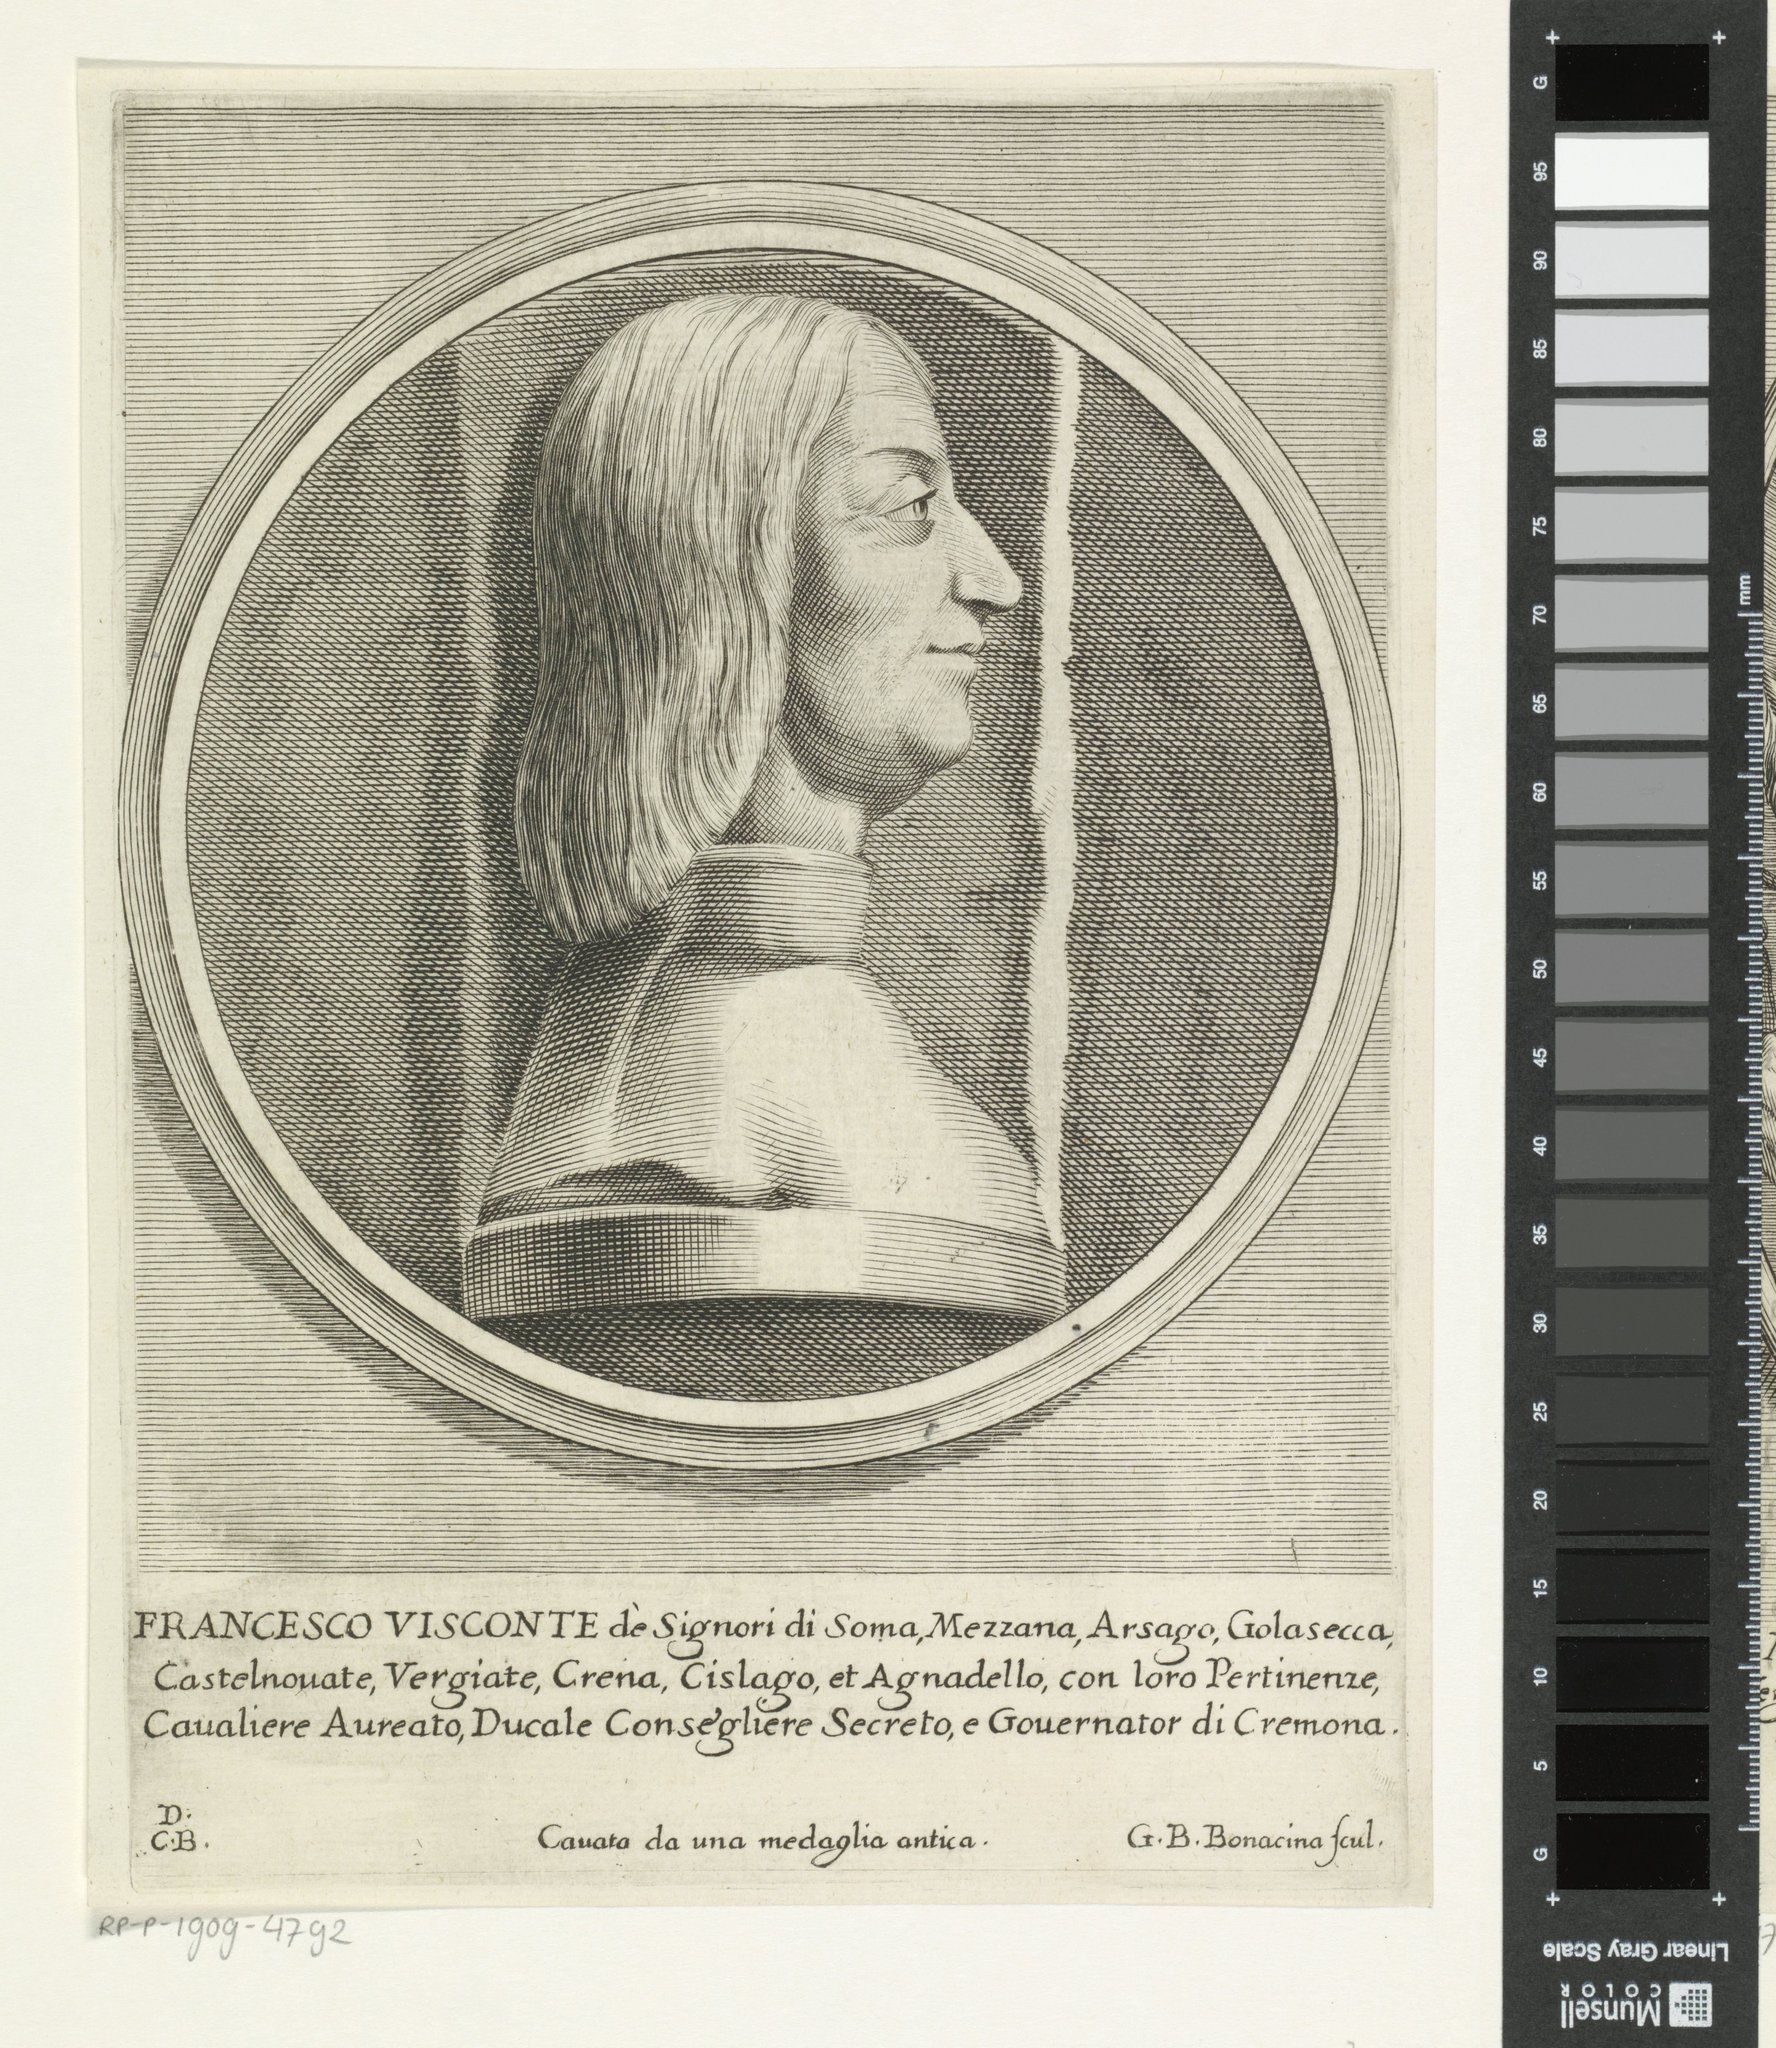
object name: print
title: Portret van Francesco Bernardino Visconti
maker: giovanni battista bonacina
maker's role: print maker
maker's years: 1615-1669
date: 1625-1669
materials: paper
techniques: engraving, etching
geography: italy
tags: historical persons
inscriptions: collector's mark: Lugt 2228